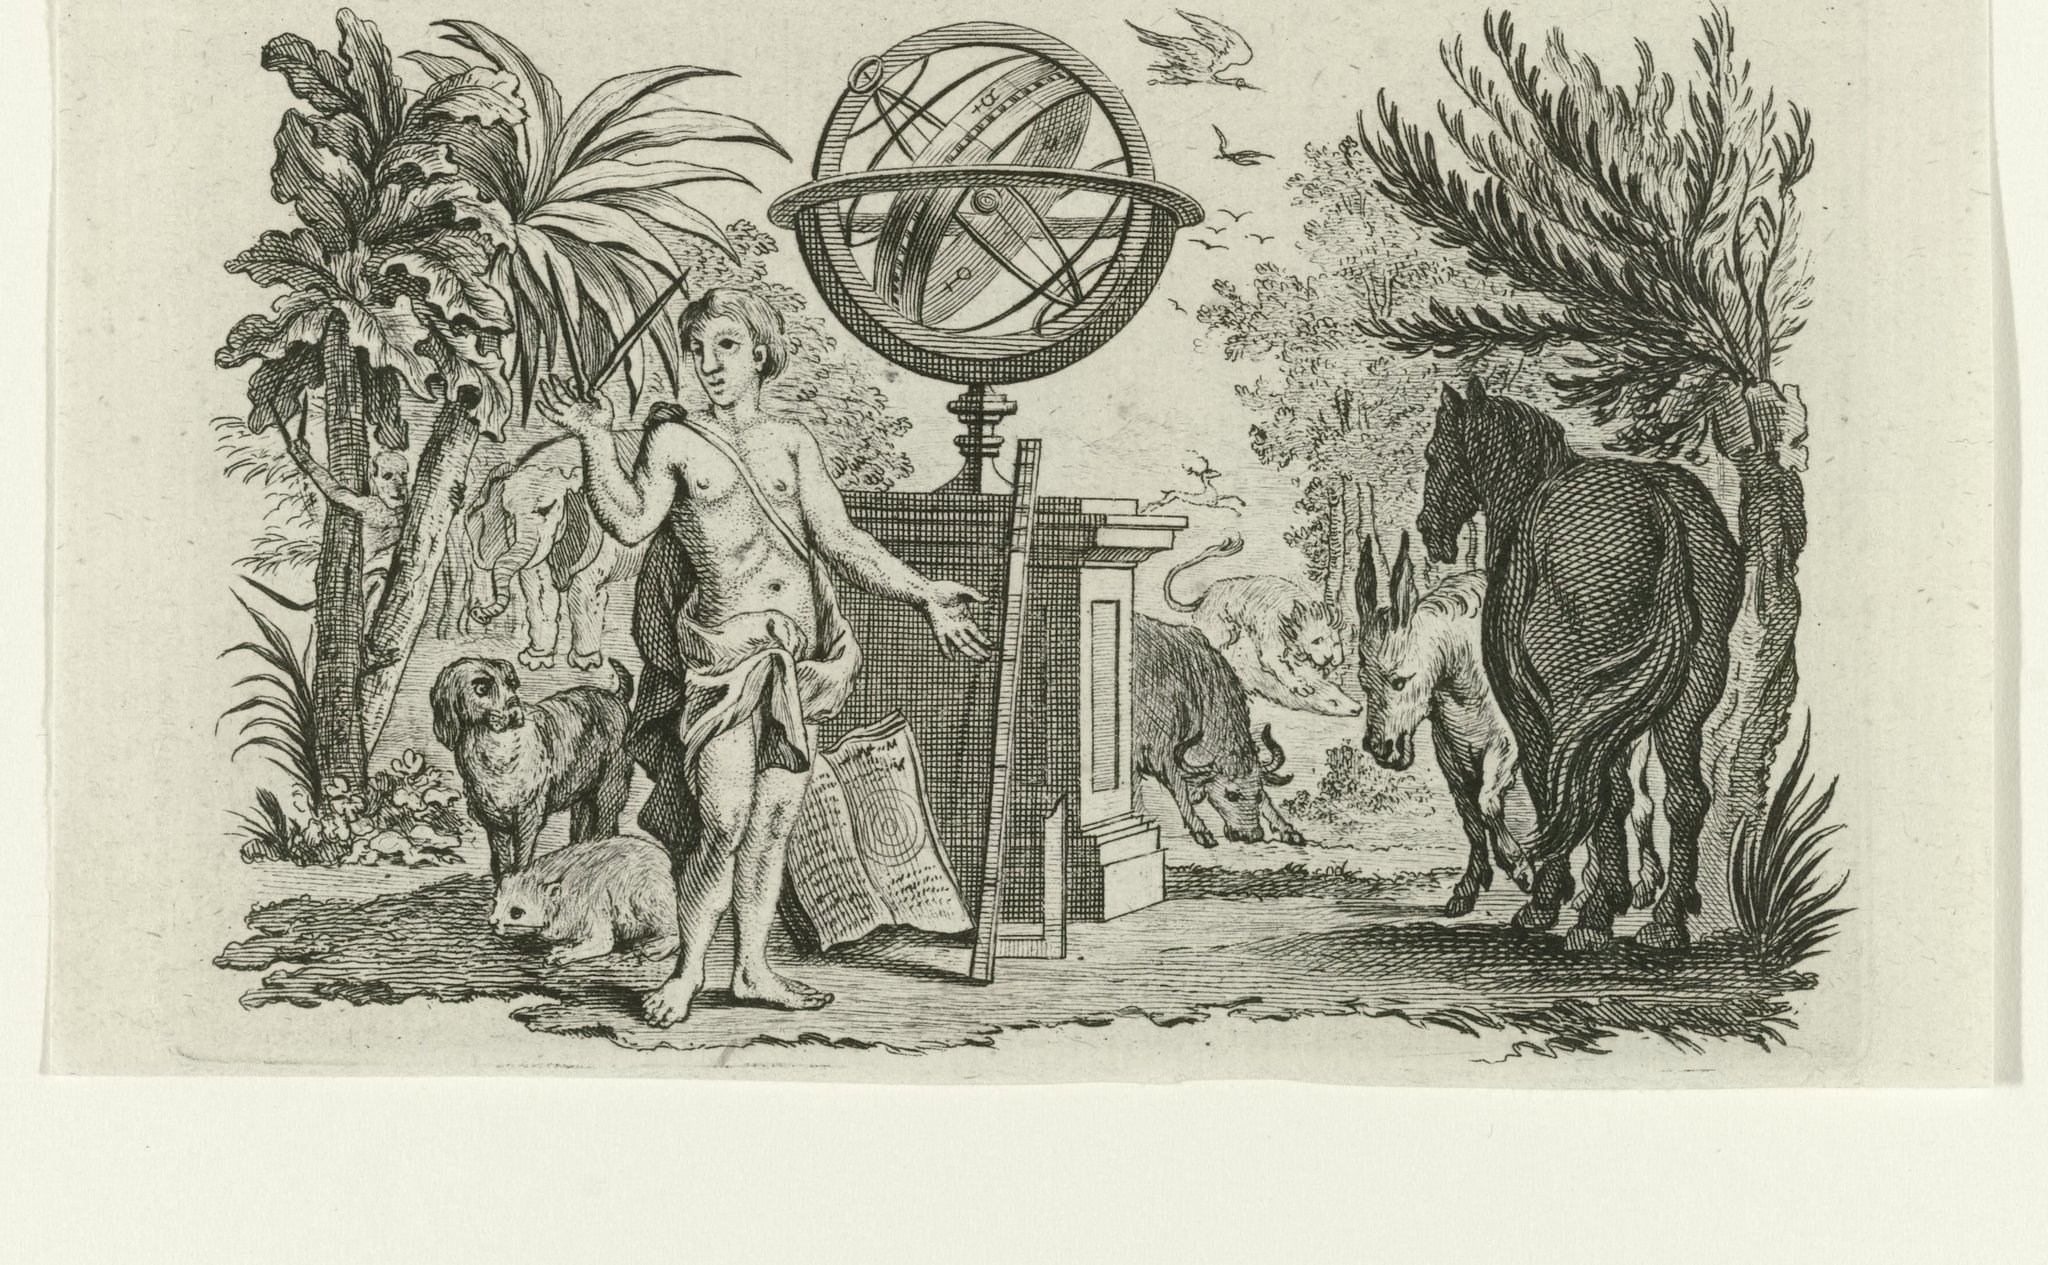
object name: print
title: Vignet met allegorie op de natuurwetenschappen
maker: Anonymous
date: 1760-1800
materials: paper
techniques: engraving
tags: adam as founder of geometry, astrolabe, star-globe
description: In een landschap met verschillende bomen en dieren staat op de voorgrond een halfnaakte man met in zijn hand een meetinstrument. Achter hem bevinden zich een astrolabium en andere instrumenten.